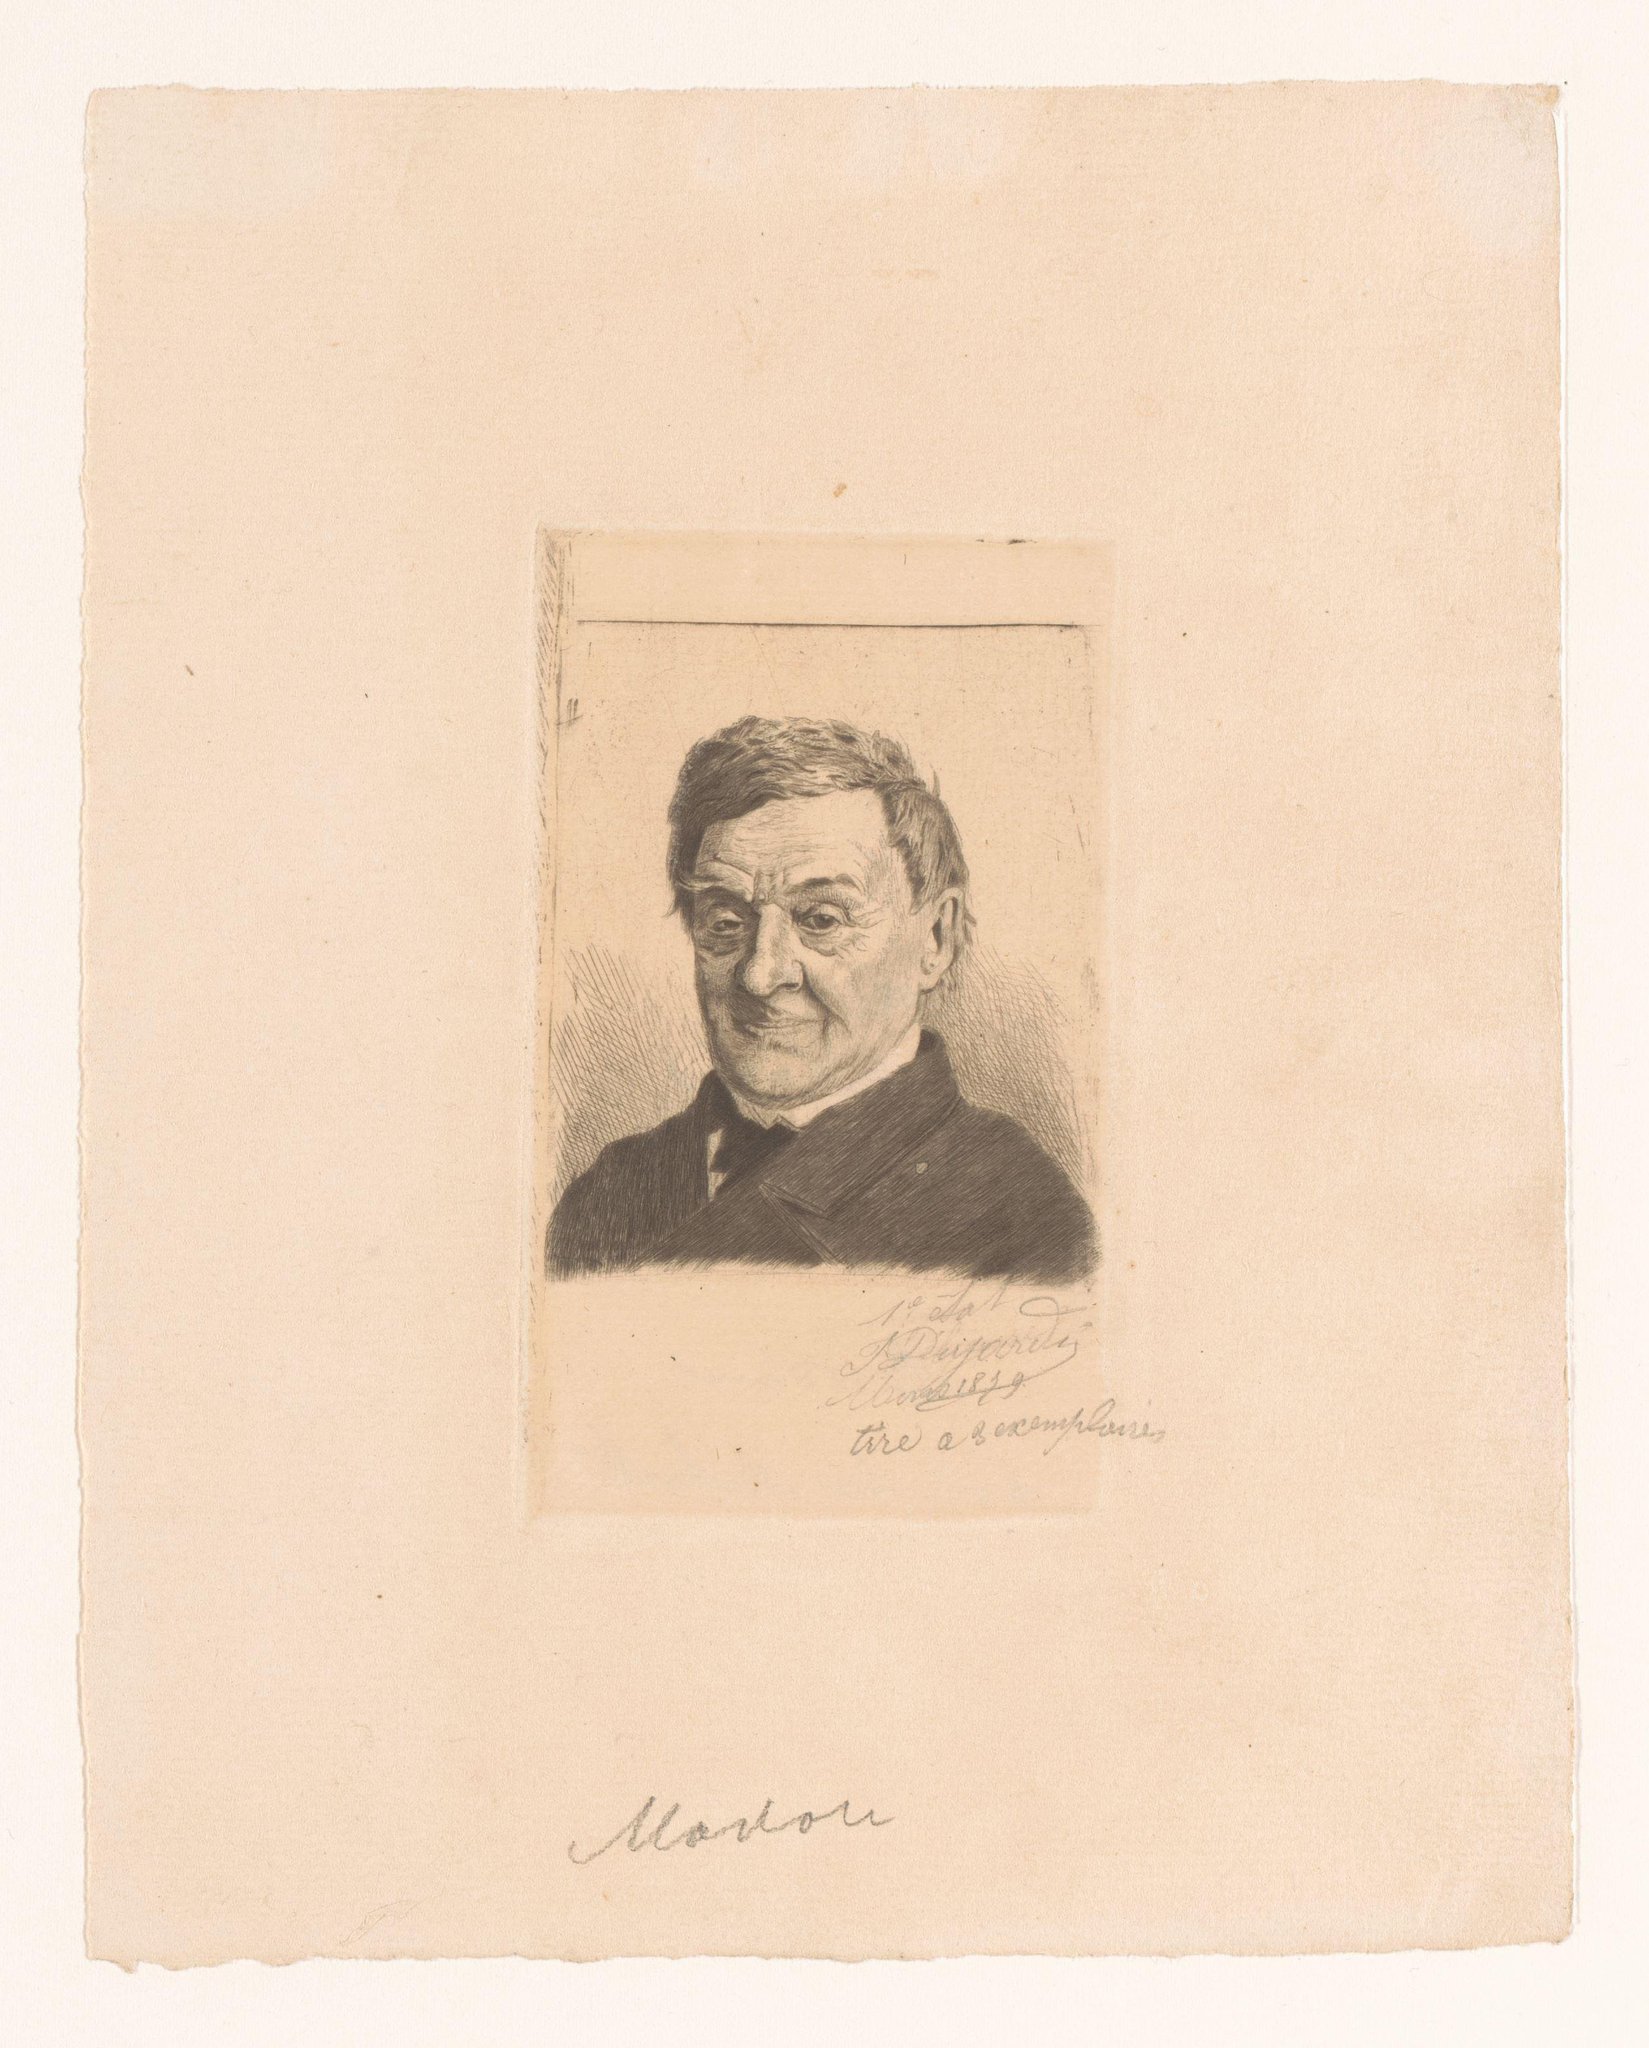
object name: print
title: Portret van een onbekende man, mogelijk Madou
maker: joseph dujardin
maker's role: print maker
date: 1879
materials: paper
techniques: drypoint, etching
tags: adult man, historical persons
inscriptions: inscription: ‘1e état; tire a 3 exemplaires’, collector's mark: Lugt 2228, inscription: ‘Madou, [...] Artiste’